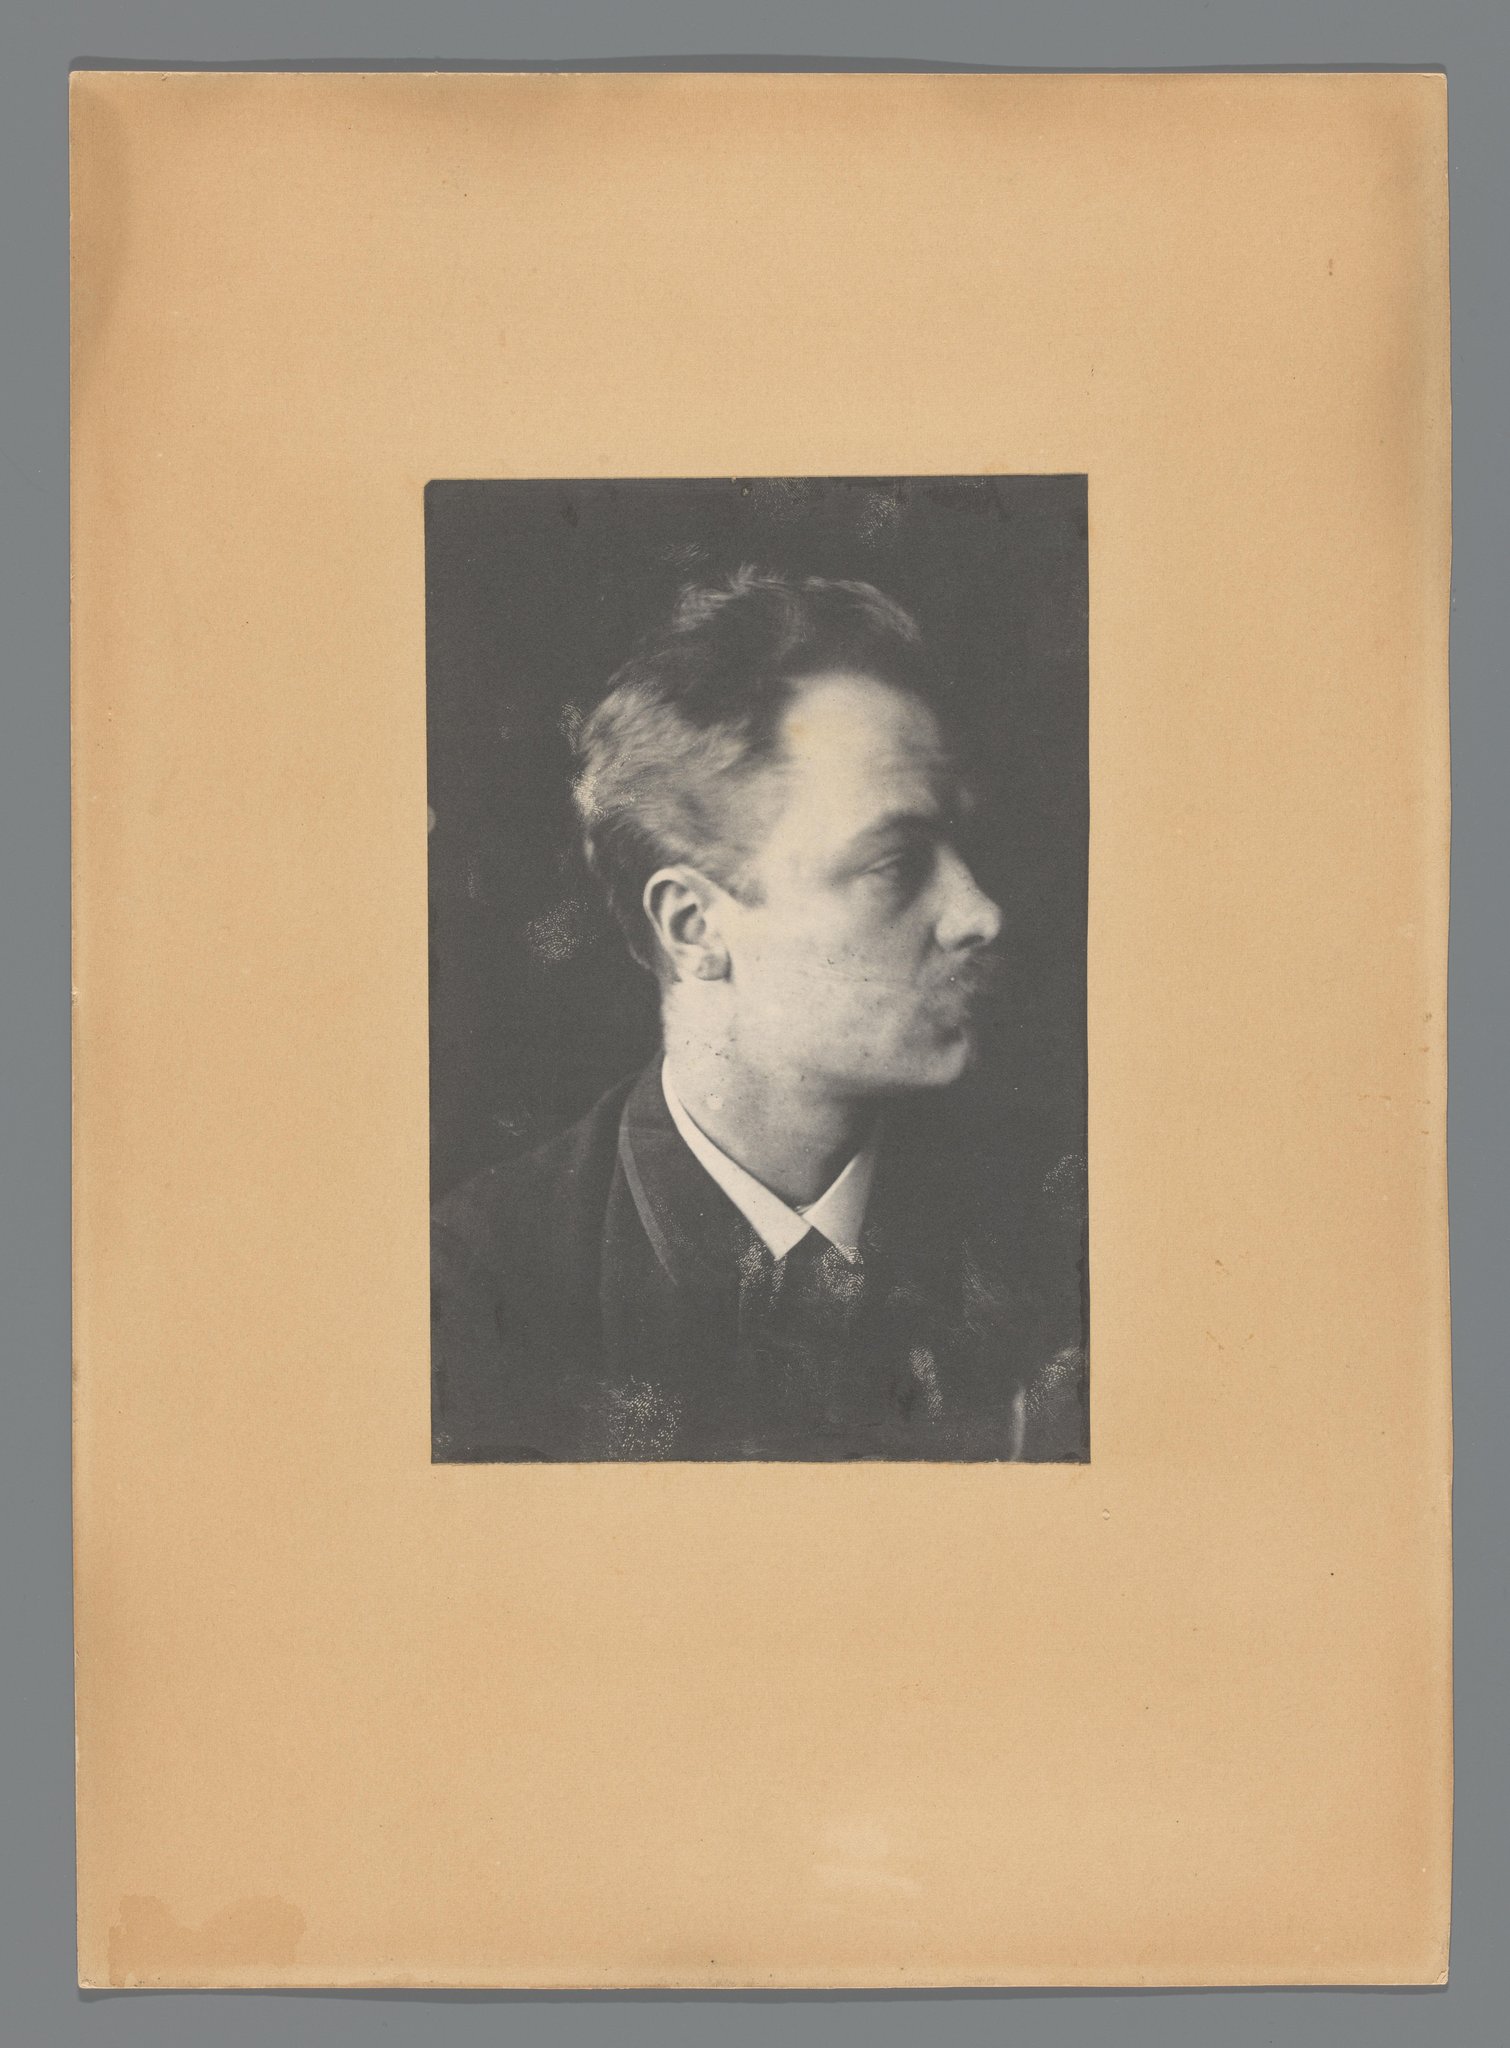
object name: photograph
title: Portret van Alphons Diepenbrock en profil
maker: joseph jessurun de mesquita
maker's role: fotograaf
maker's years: 1865-1890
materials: cardboard, photographic support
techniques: photolithography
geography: netherlands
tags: alphons diepenbrock, portrait of composer